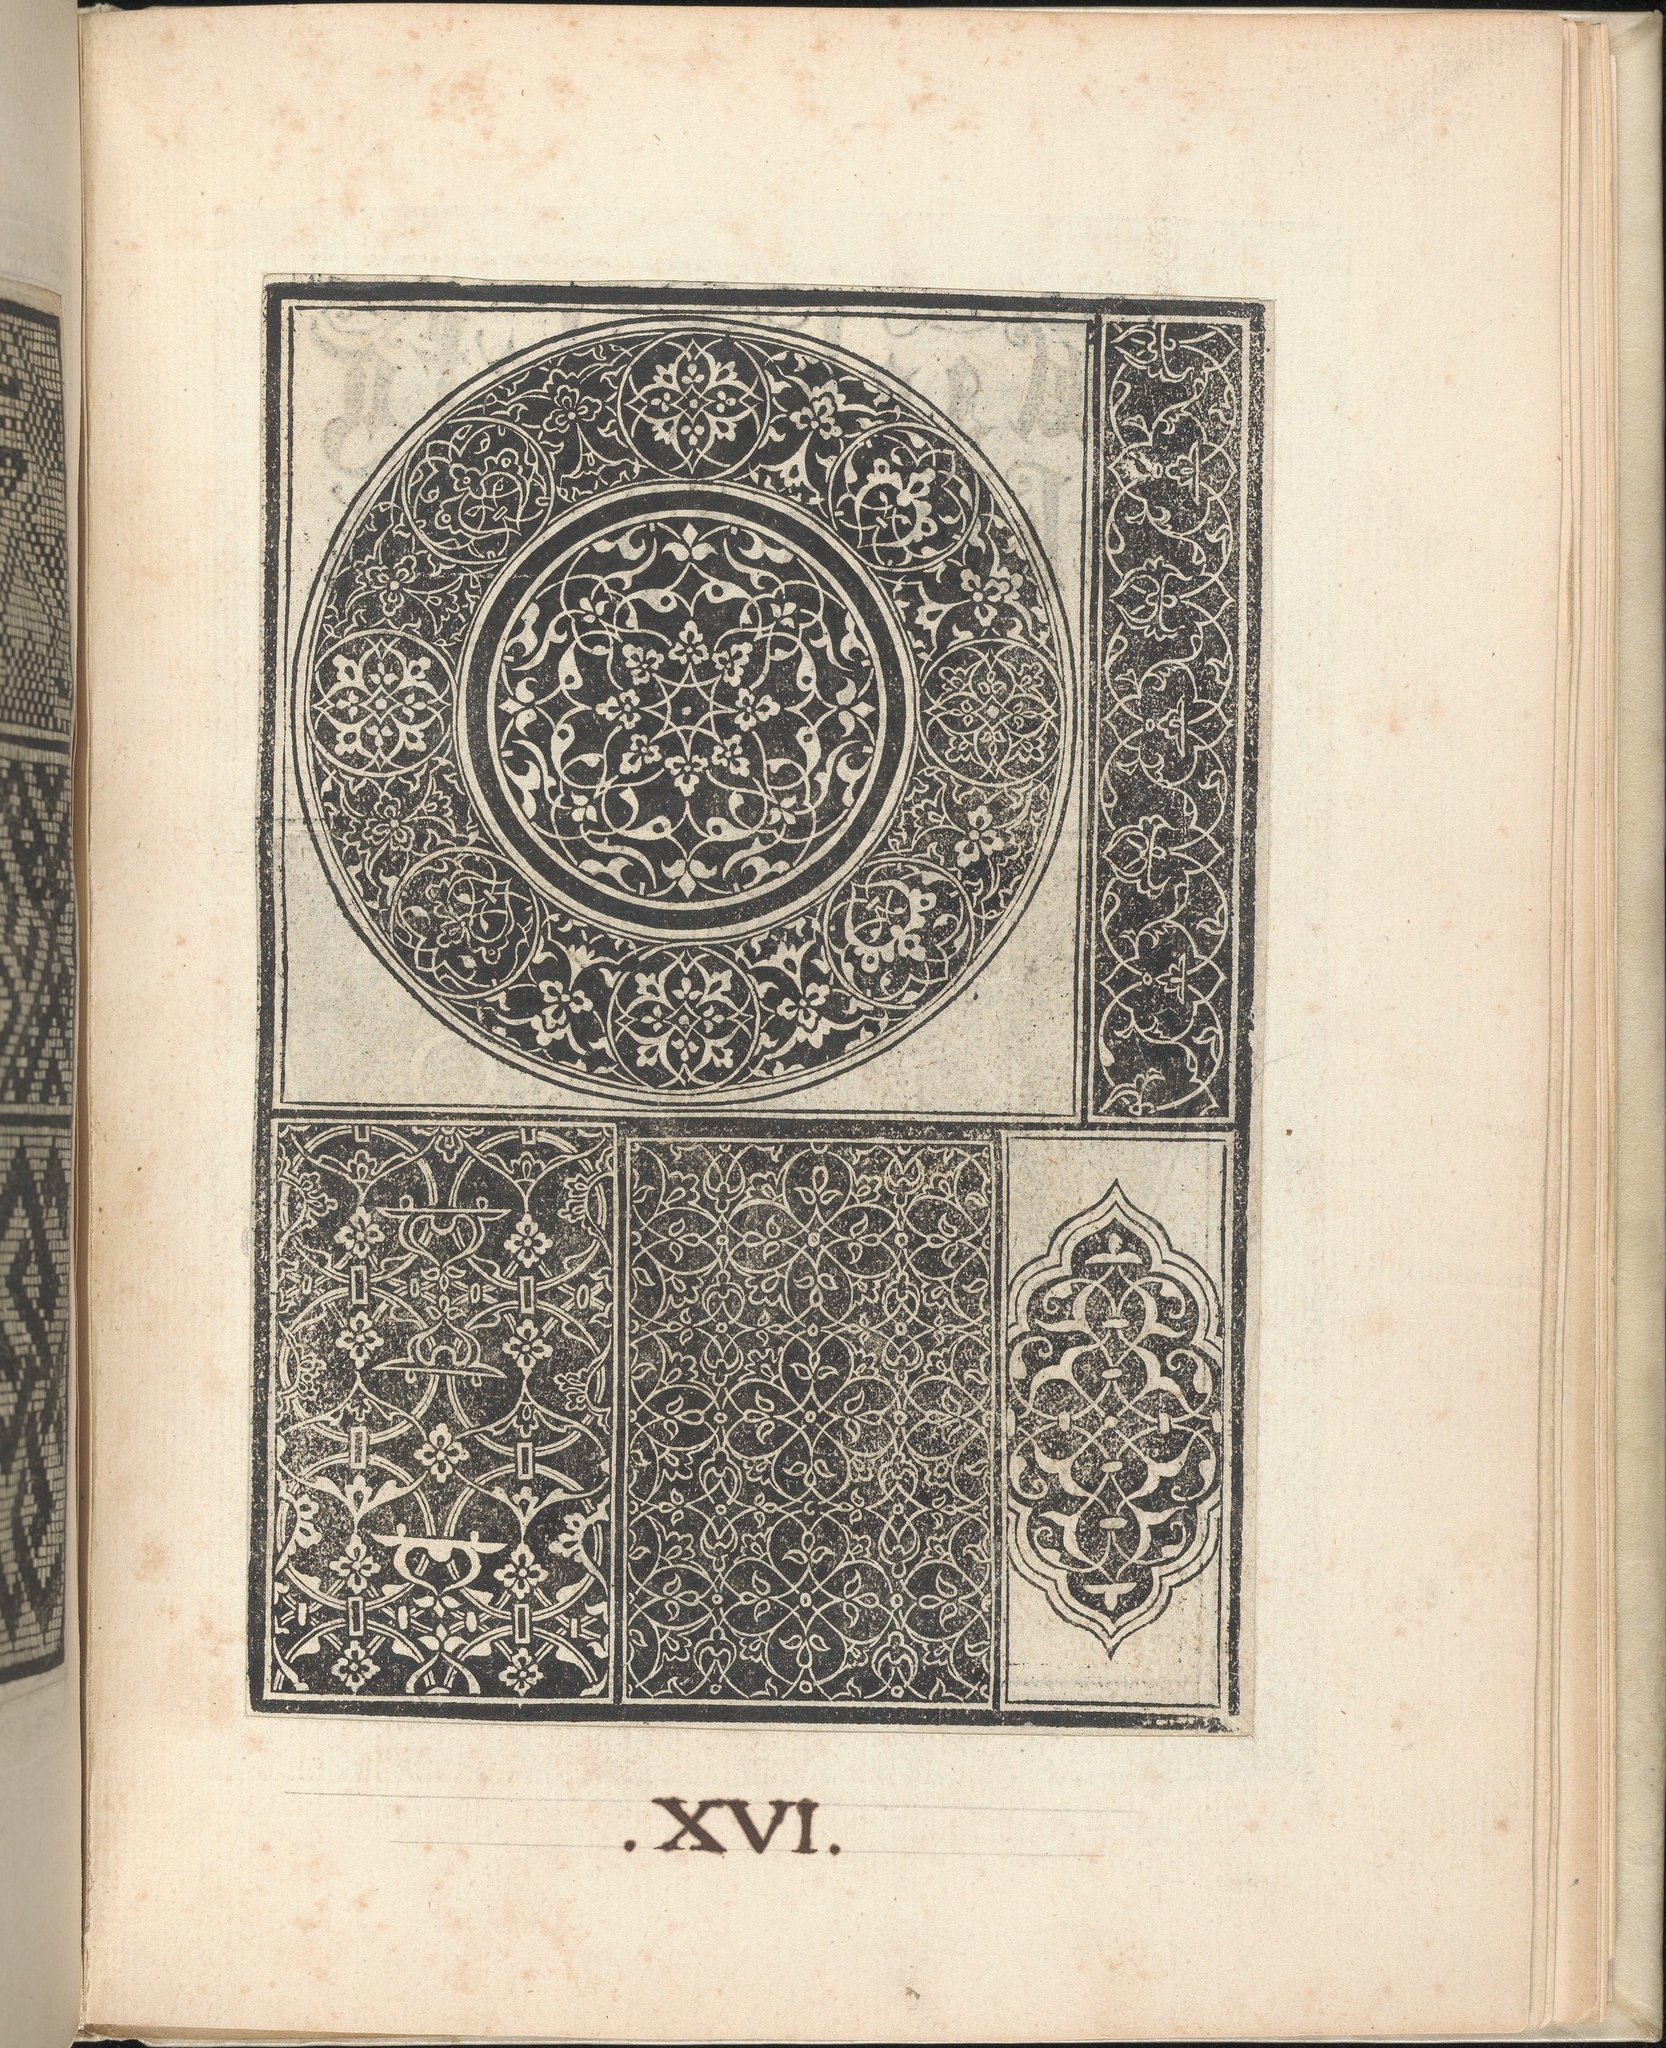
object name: book print ornament architecture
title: Esemplario di lavori, page 15 (verso)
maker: nicolò zoppino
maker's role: publisher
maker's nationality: italian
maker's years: 1478-1544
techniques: bookbinding, inlay, woodcut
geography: italy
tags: ornament